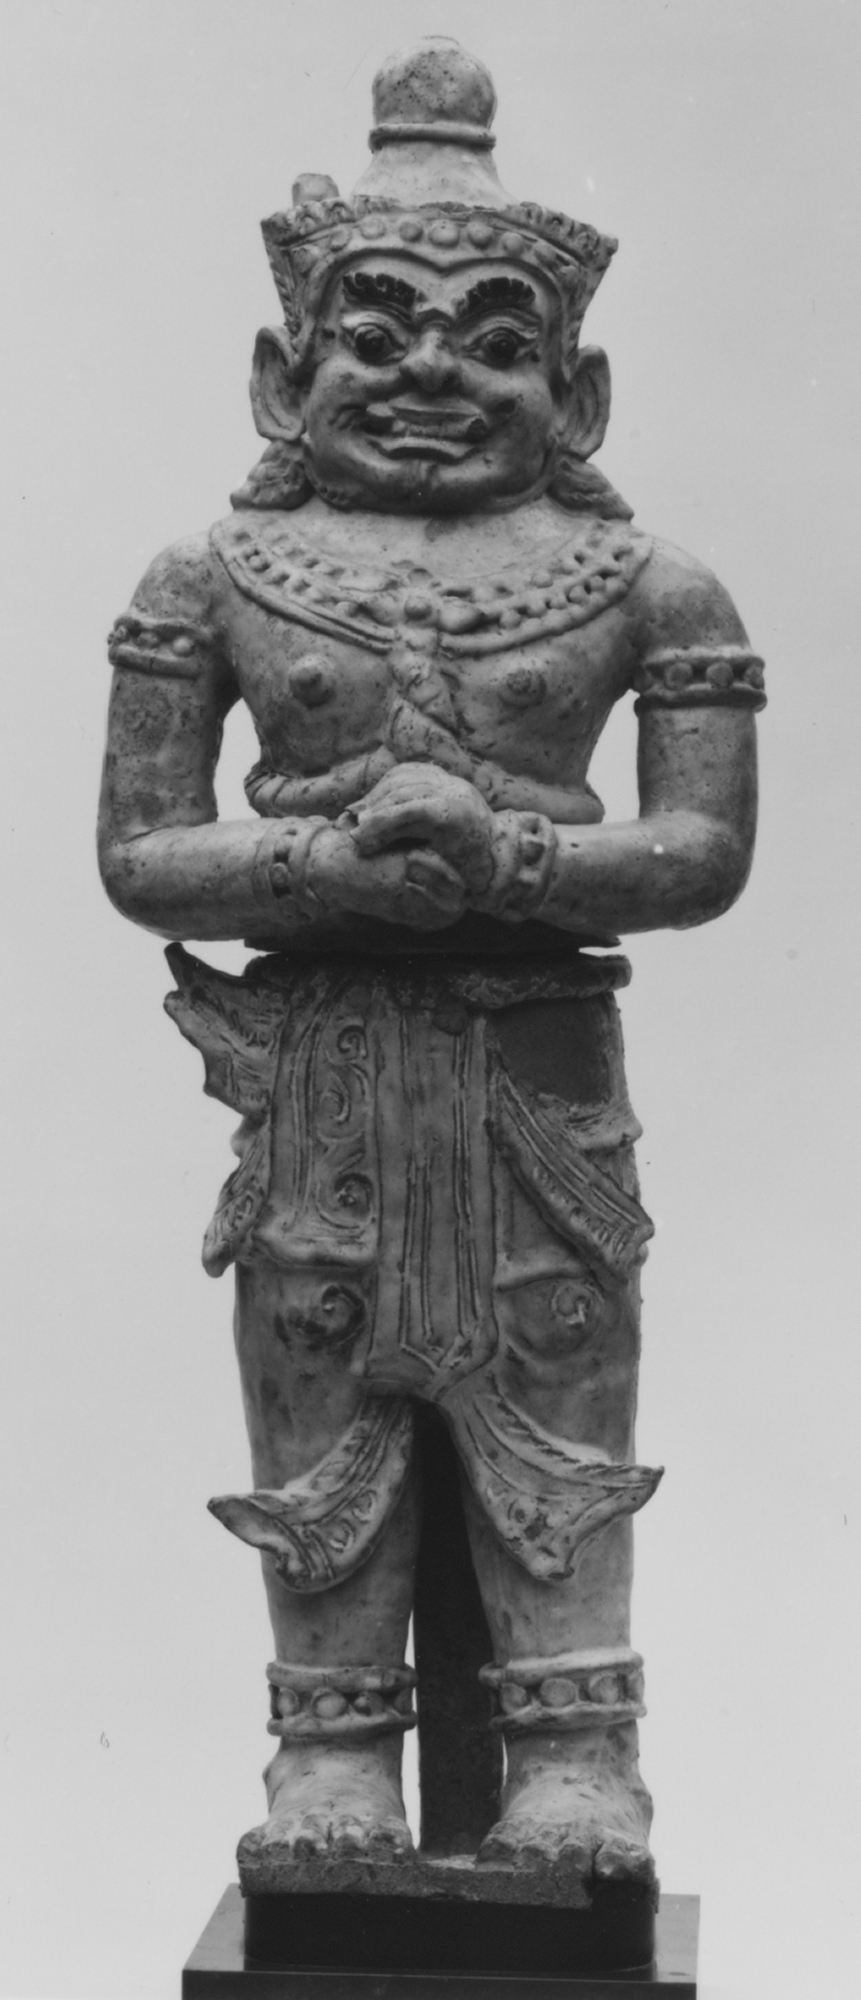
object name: figure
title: Standing Guardian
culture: thai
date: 1401-1500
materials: pottery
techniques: glazing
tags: men